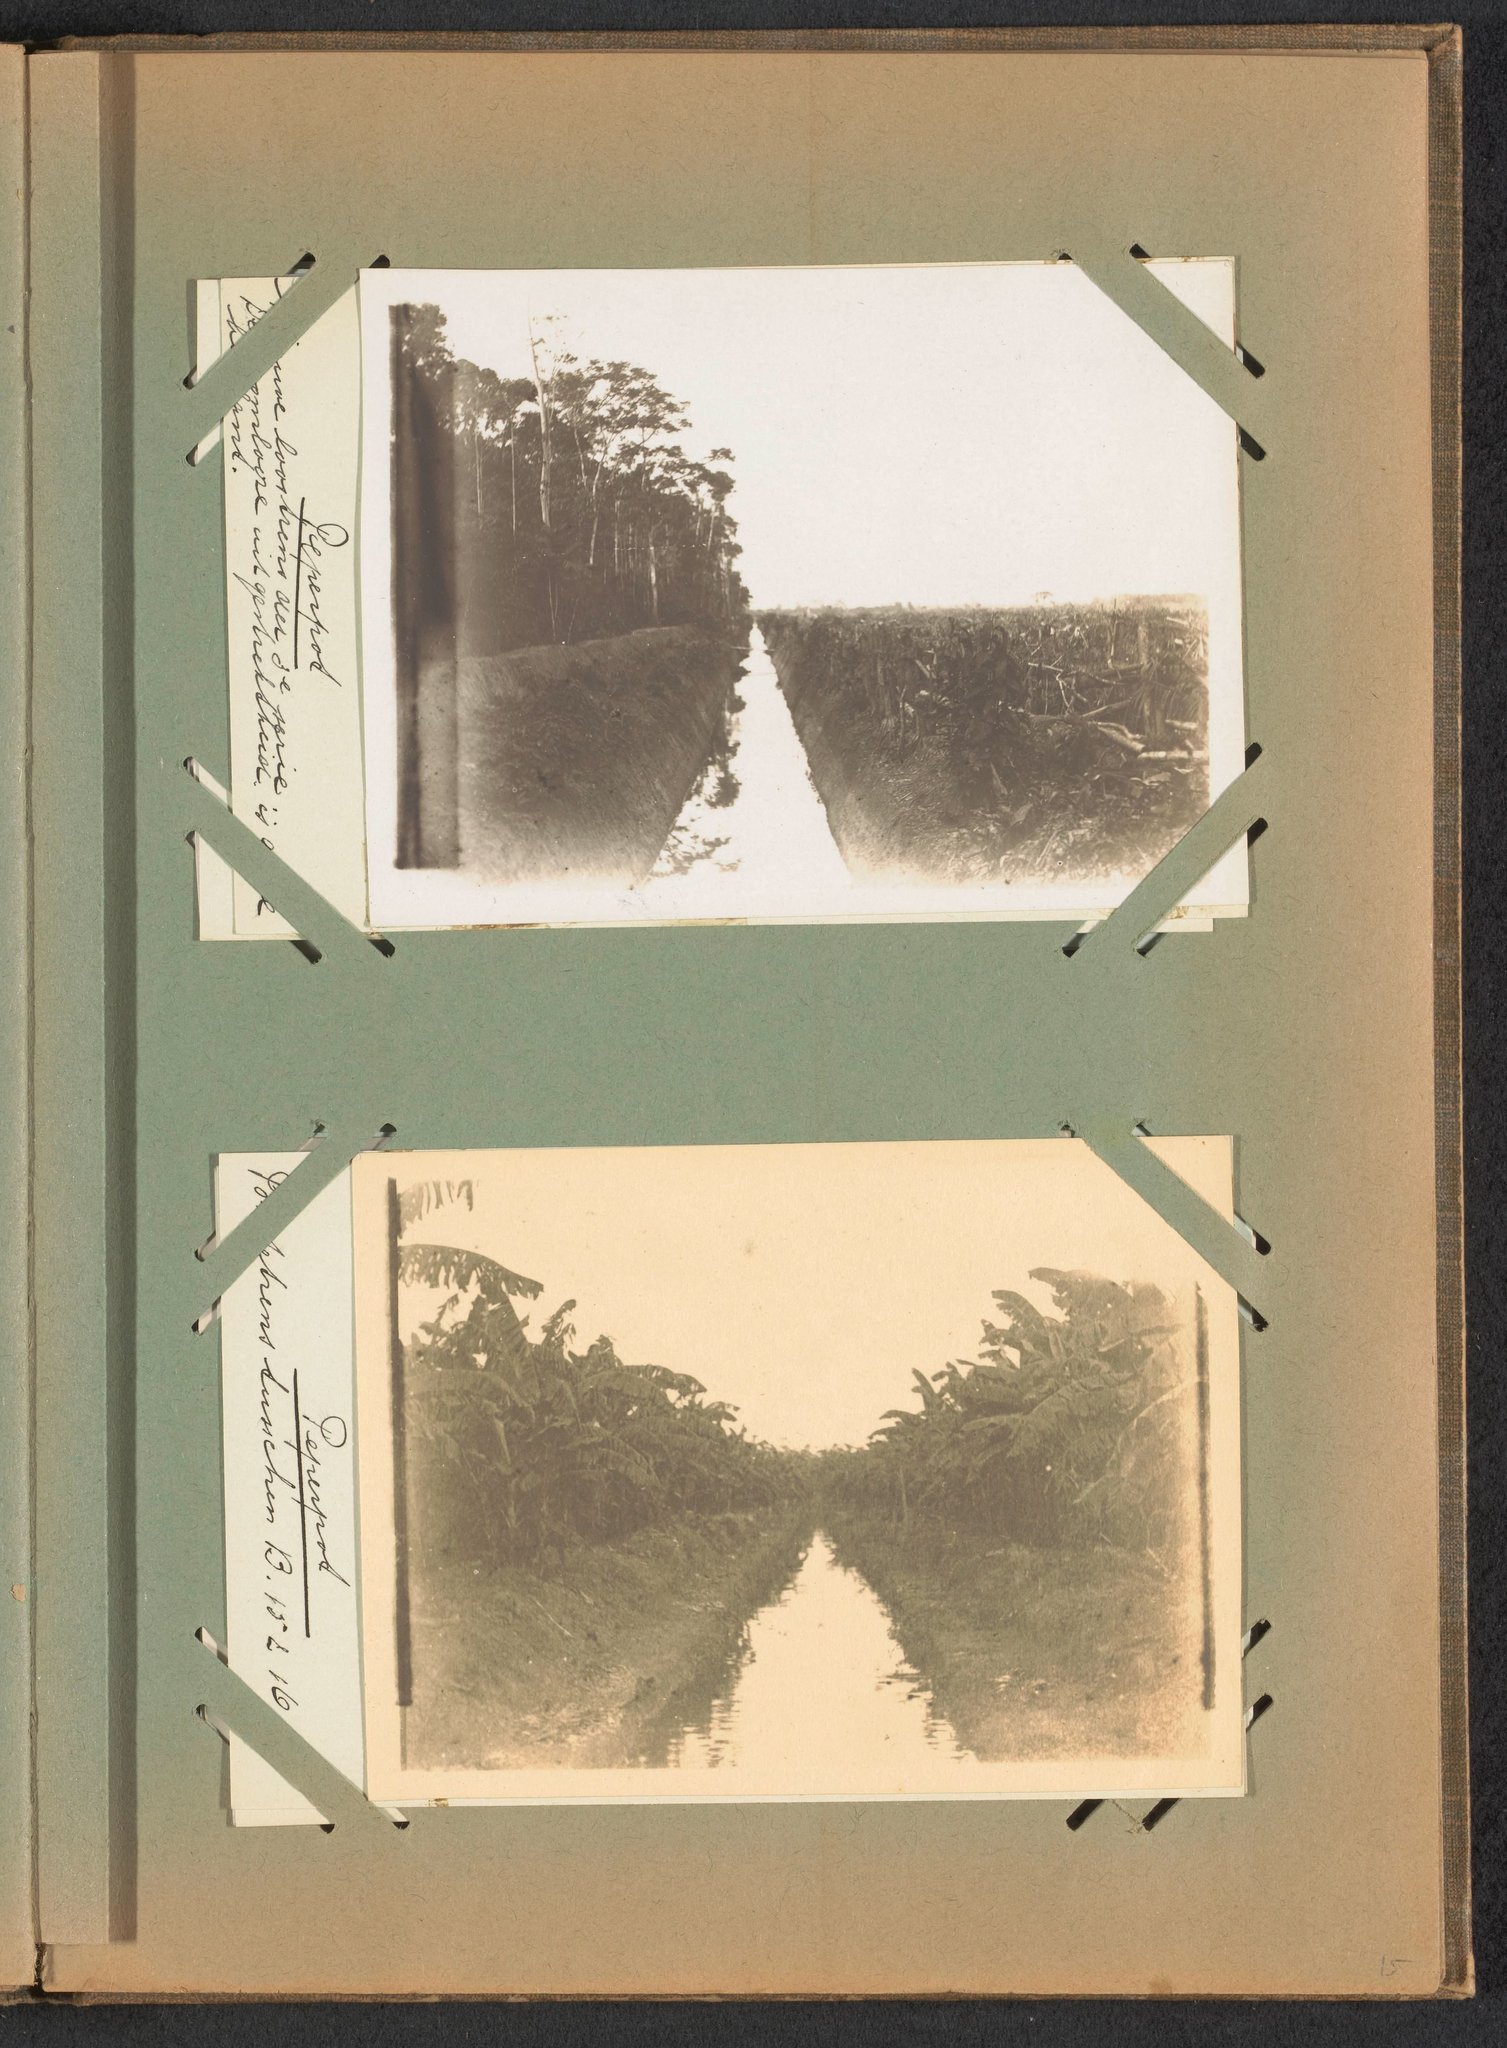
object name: photograph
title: Vaart op Plantage Peperpot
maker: Anonymous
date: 1912-1913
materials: paper, photographic support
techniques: gelatin silver print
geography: suriname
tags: plantation, suriname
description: Vaart op Plantage Peperpot in Suriname. Onderdeel van het fotoalbum uit ca. 1912-1913 met 92 foto's van de plantages Peperpot en Dordrecht in Suriname en Mount Pleasant op Curaçao.